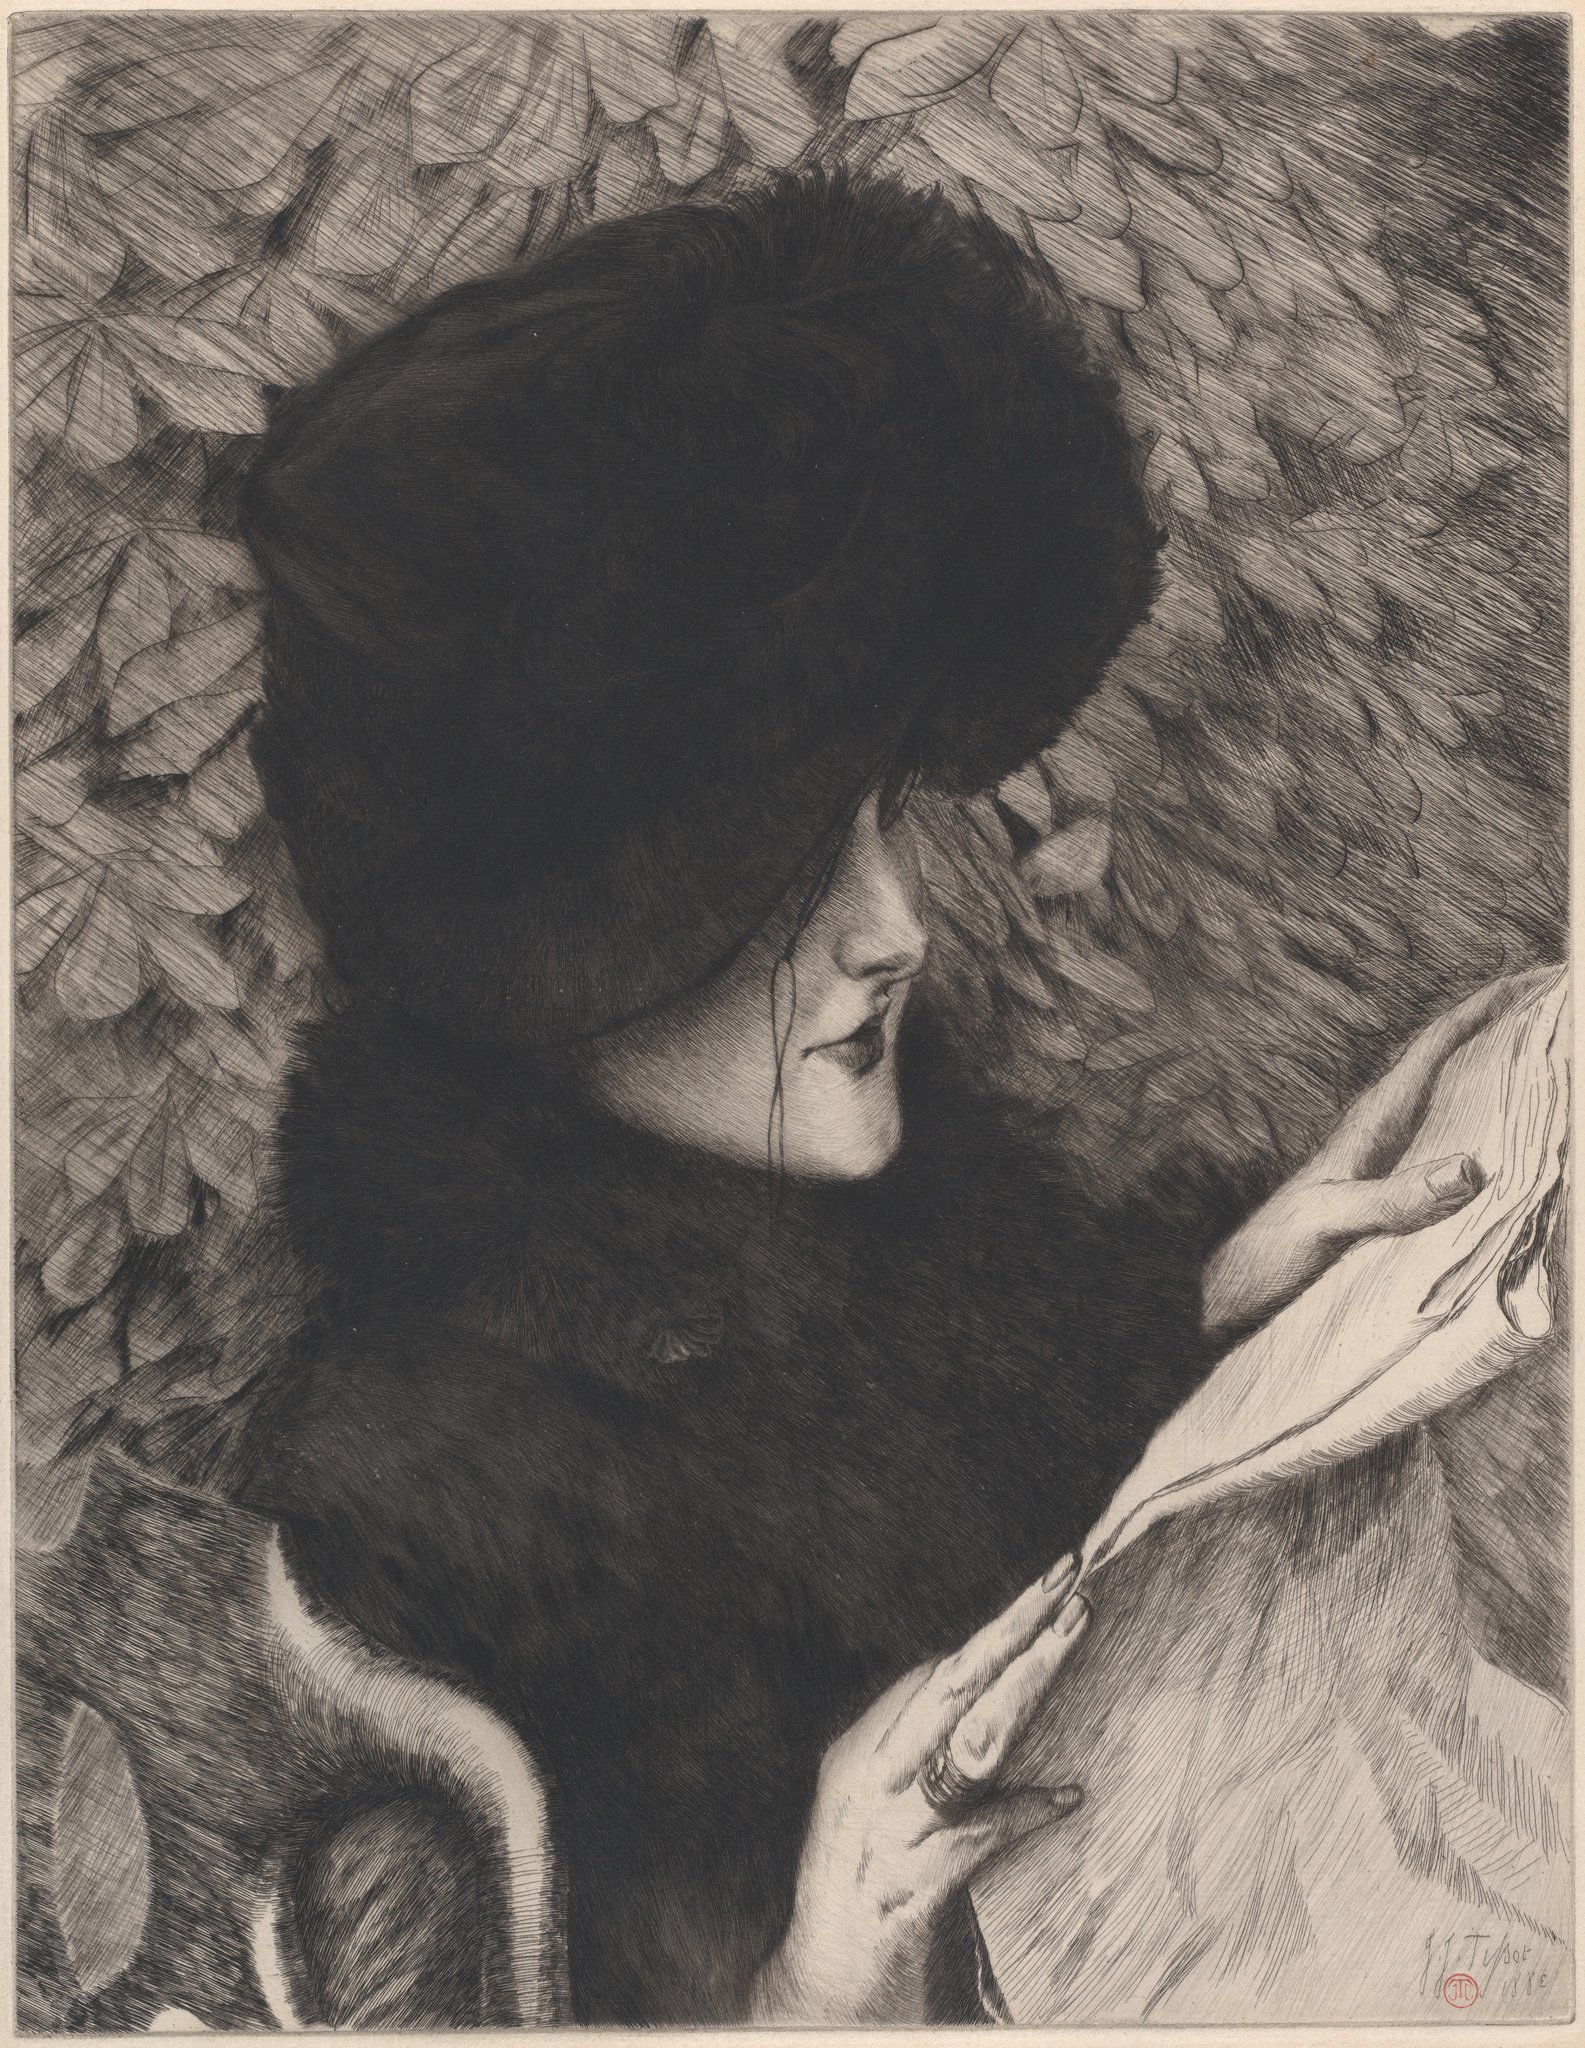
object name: print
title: The Newspaper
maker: james tissot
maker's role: artist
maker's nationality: french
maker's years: 1836-1902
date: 1883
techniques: drypoint, etching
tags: women,reading,newspapers